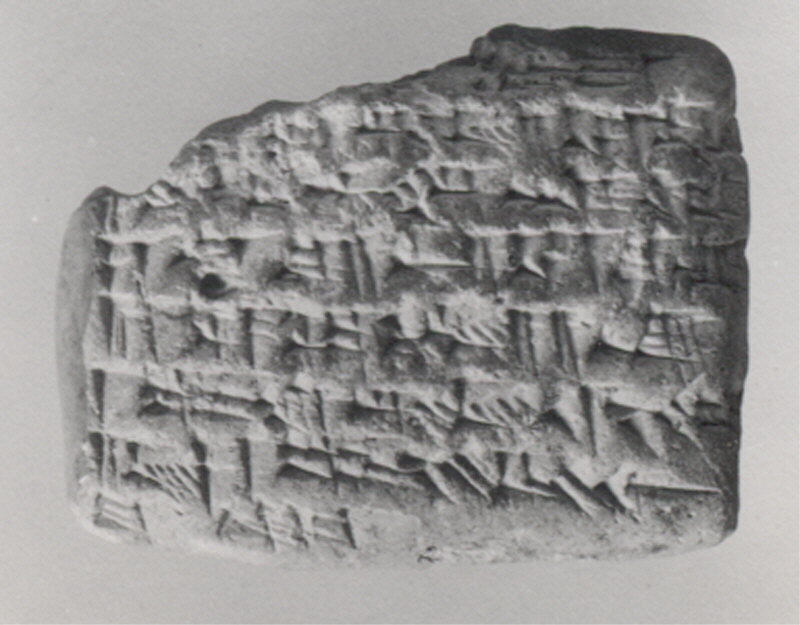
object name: cuneiform tablet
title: Cuneiform tablet: quittance for dates, Esagilaya archive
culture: babylonian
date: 540 BCE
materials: clay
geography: mesopotamia